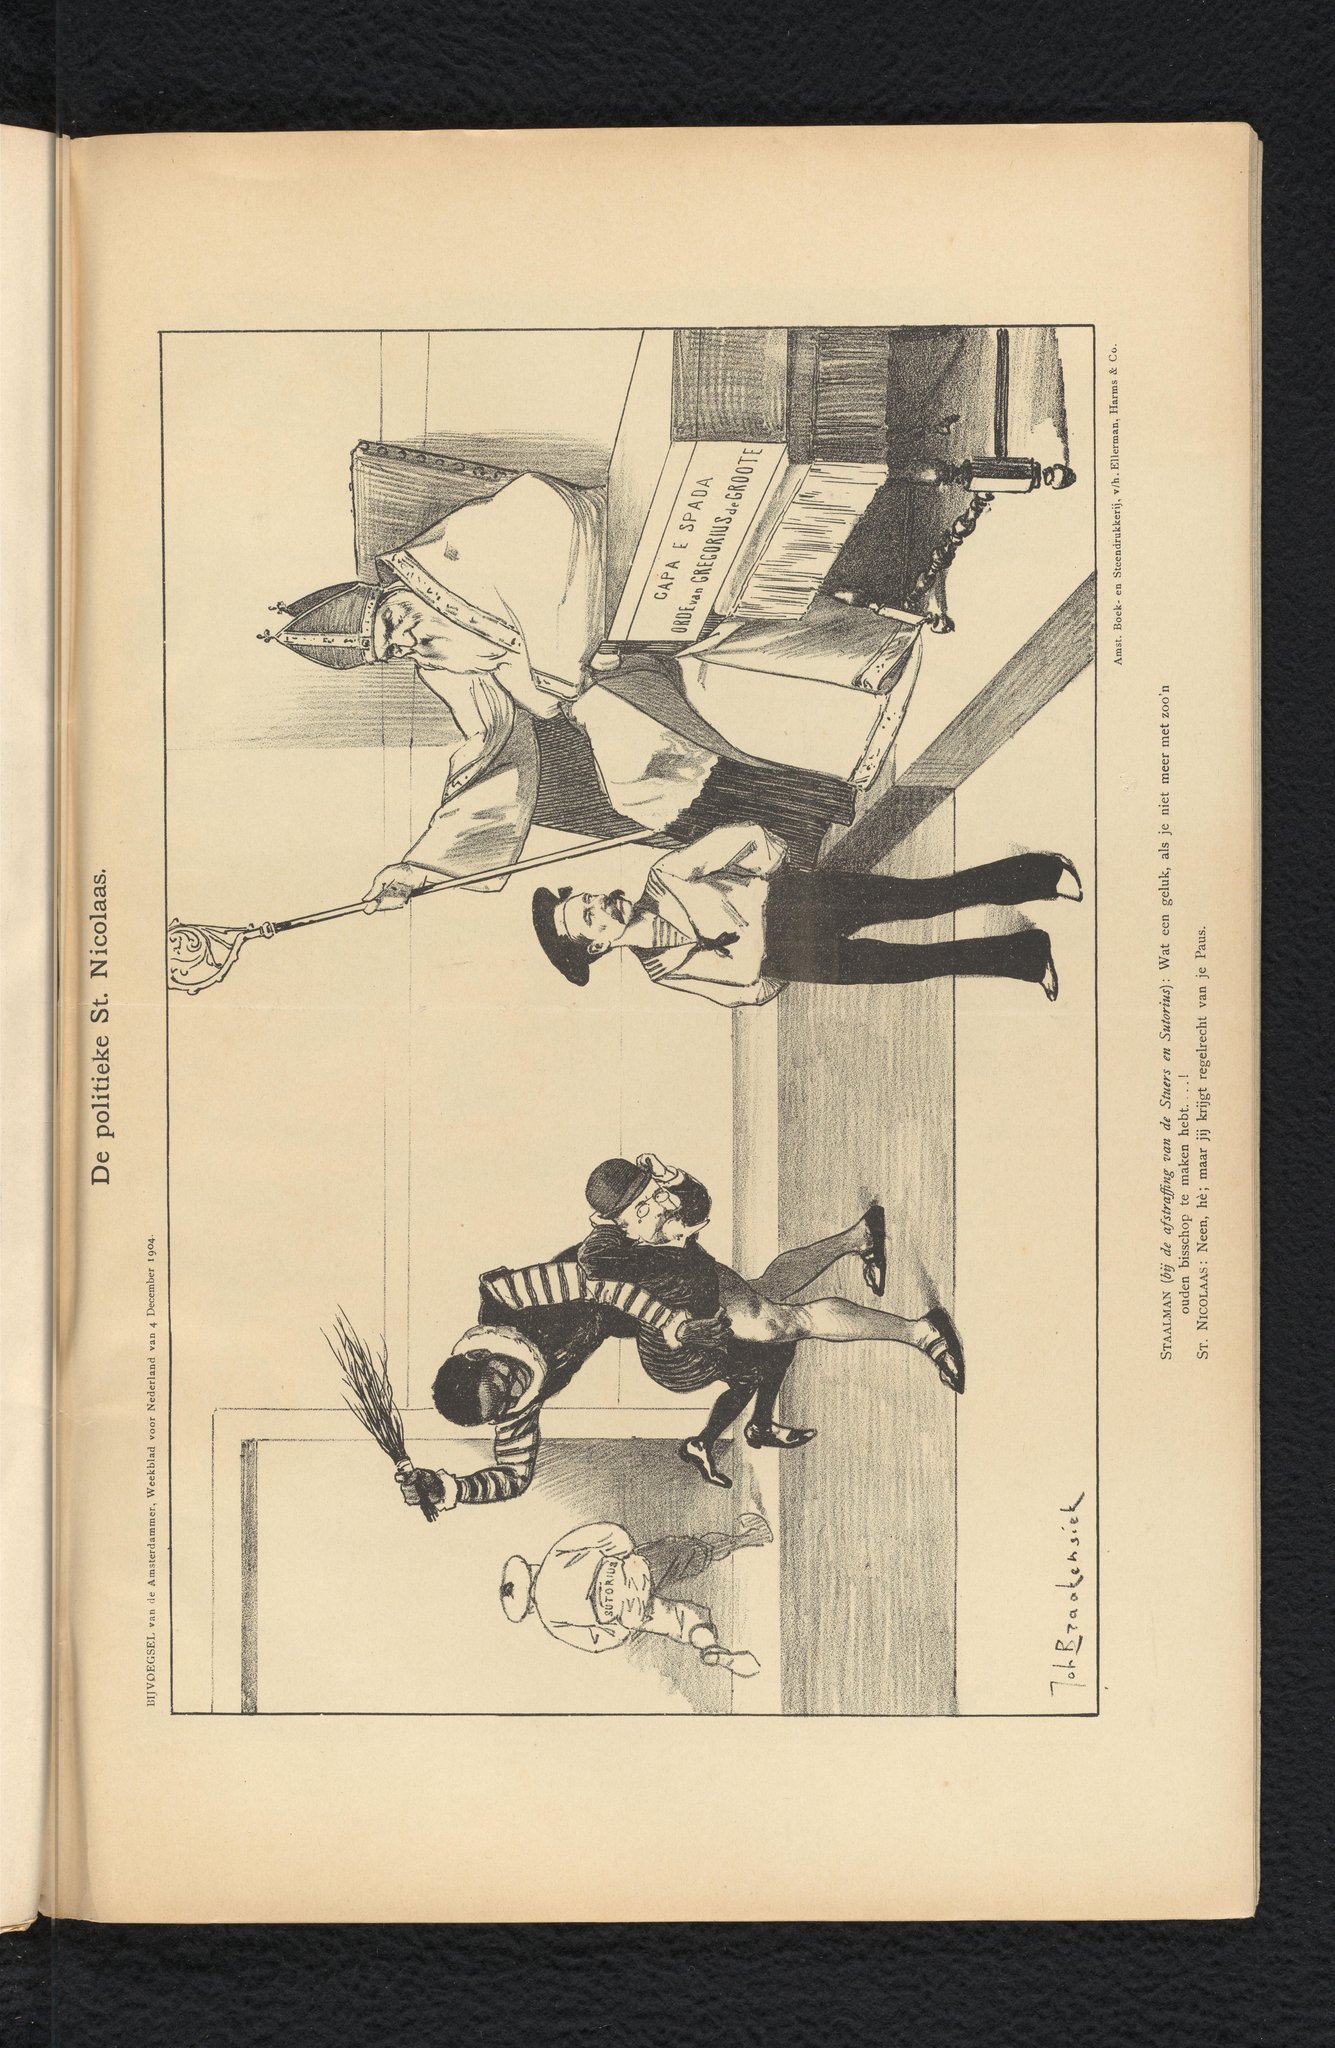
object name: cartoon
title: De politieke St. Nicolaas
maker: johan braakensiek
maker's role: draughtsman, print maker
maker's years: 1858-1940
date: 1904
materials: paper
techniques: lithograph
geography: netherlands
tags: maastricht, the hague, victor de stuers, festivities on st. nicholas (eve) (december 5), political caricatures and satires, saint nicholas day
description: Tweede Kamerlid Andries Staalman krijgt van Sint Nicolaas te horen dat hij ook zijn straf zal ontvangen, Links krijgen Sutorius en Victor de Stuers met de roe slaag van Zwarte Piet.